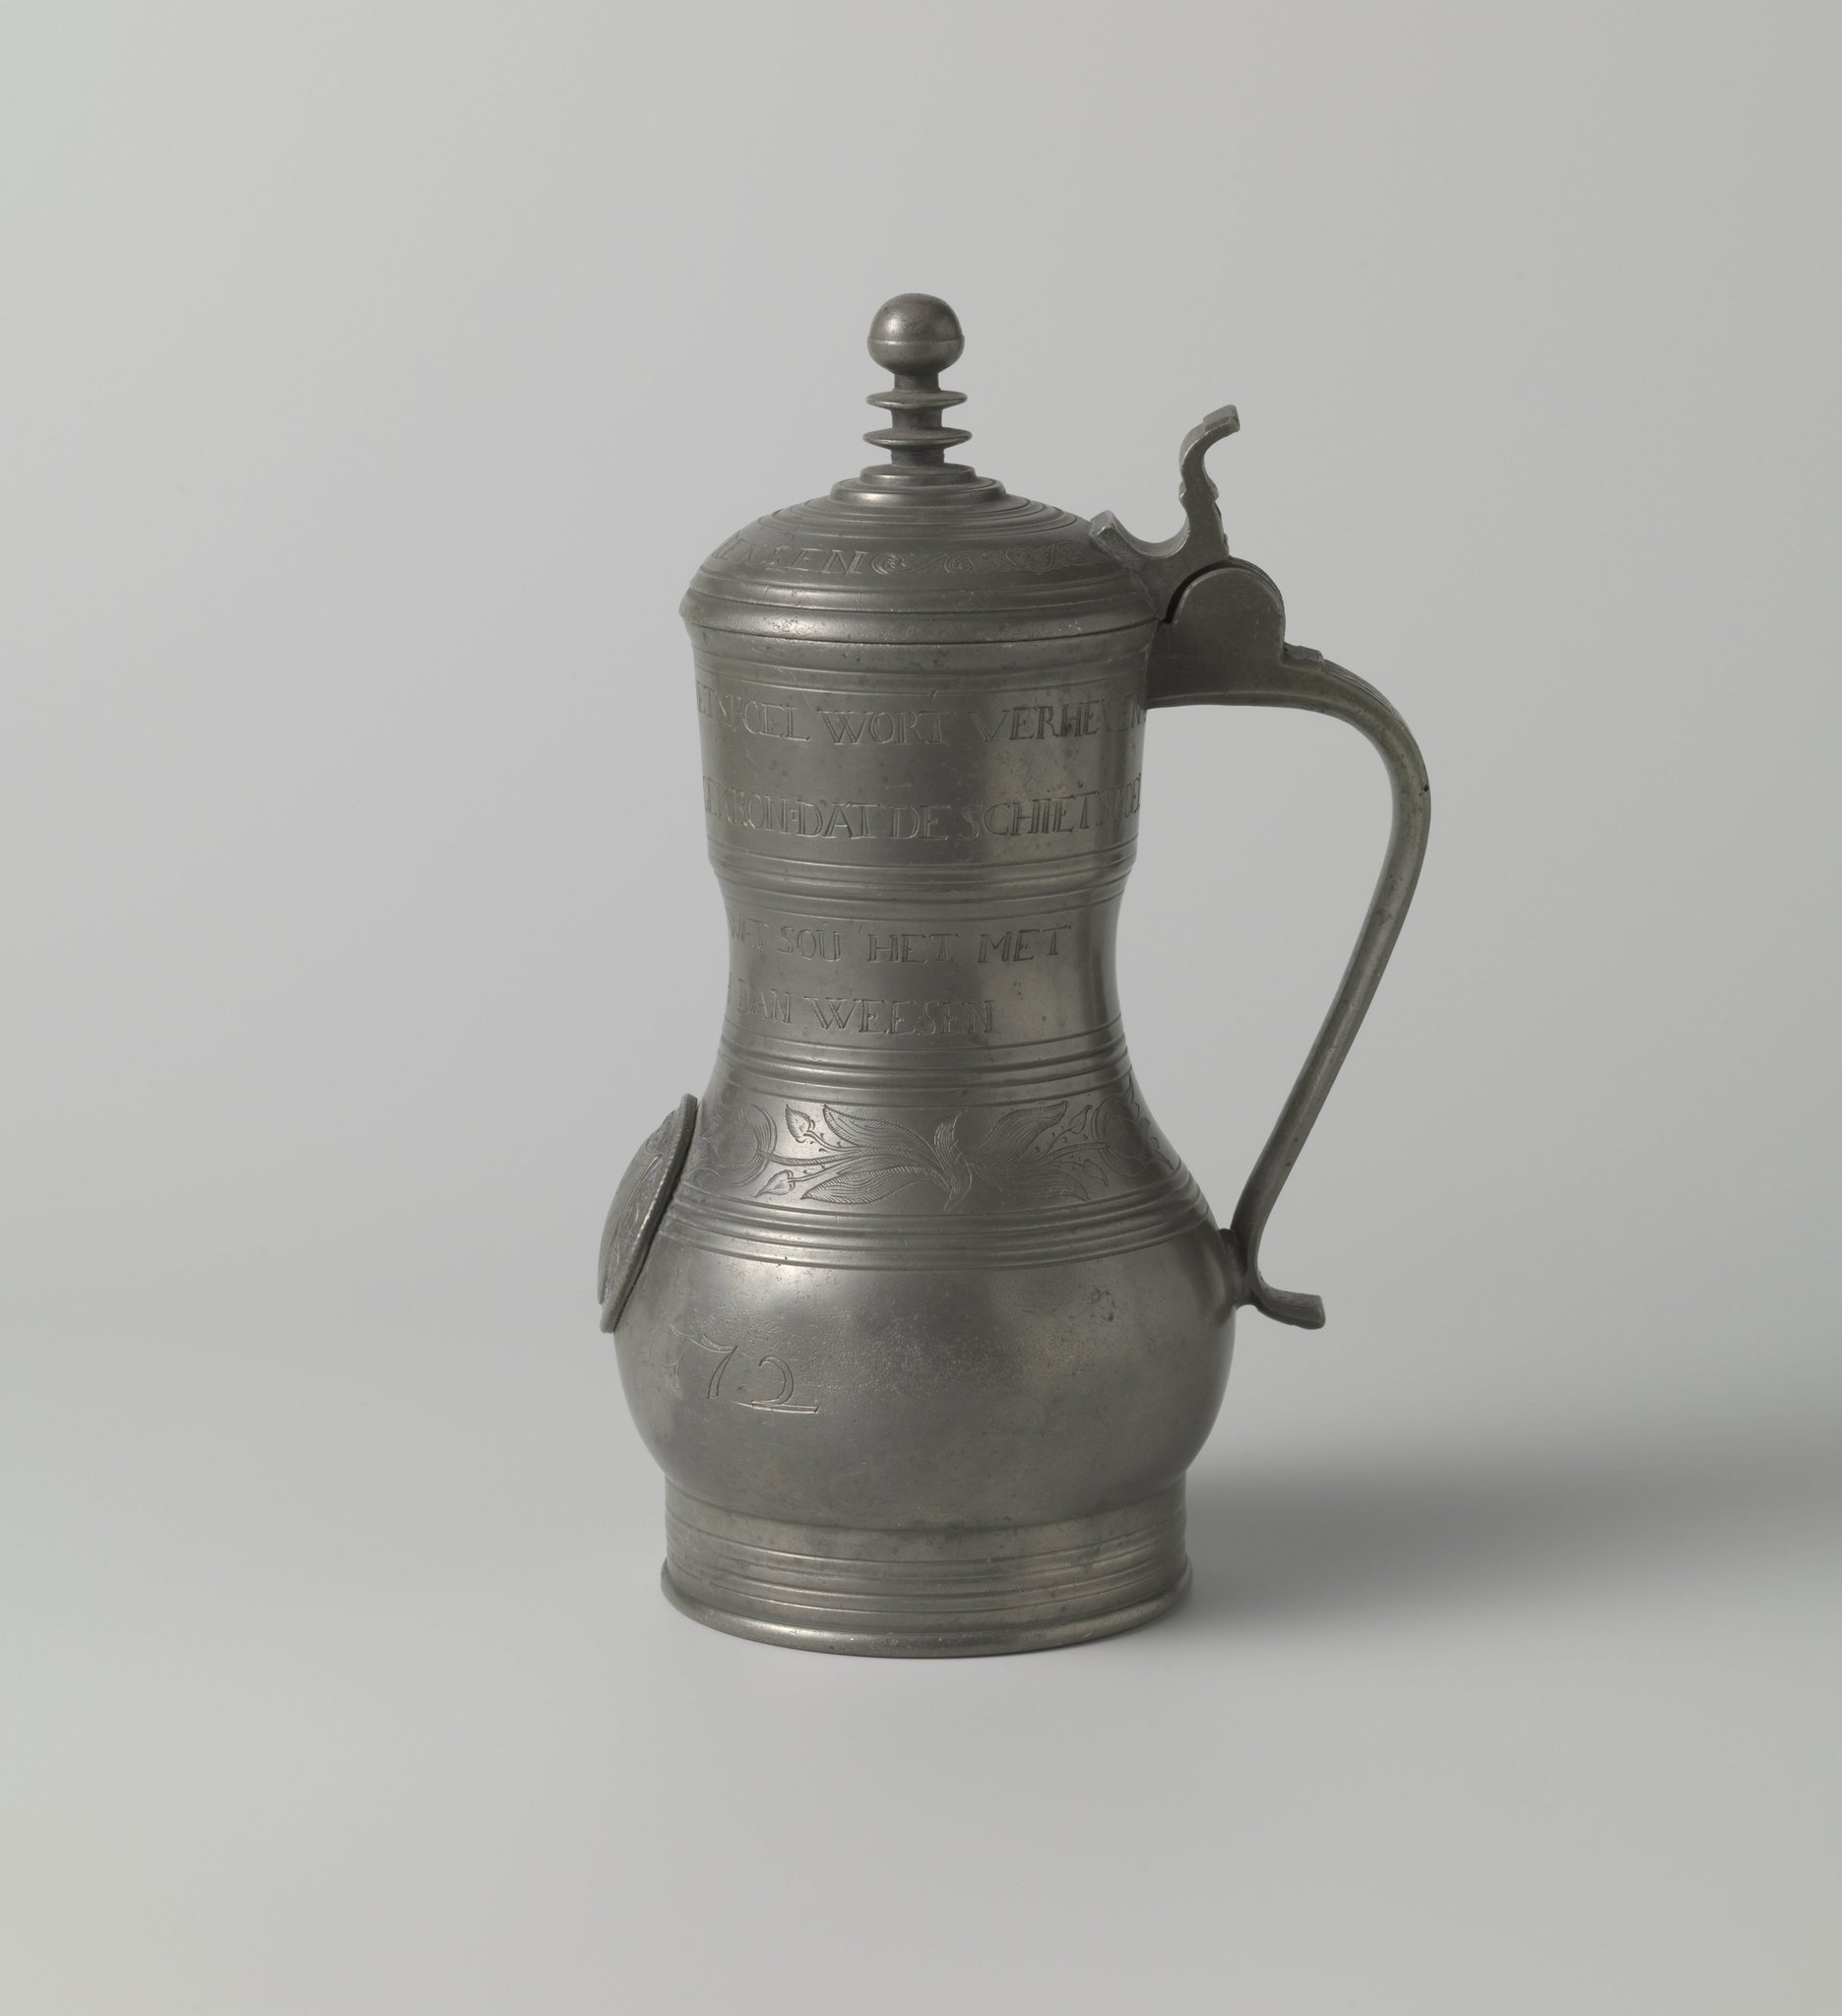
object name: jug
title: Gildekan van tin voor het werversgilde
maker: matthijs van ooyen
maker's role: pewterers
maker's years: 1679-1728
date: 1708-1772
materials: tin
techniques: casting, engraving, turning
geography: nijmegen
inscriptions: inscription: ‘PETER LAURENSEN’, quality mark, inscription: ‘O SALIG WEVEN DE SCHITESPOEL WORT VERHEVEN / DE SPHENROEKEN WORT GEKRON DAT DE SCHIETSPOEL / NIET WIERT GEDREVEN WAT SOU HET MET / DEN ARMEN MENSCH DAN WEESEN / ANNO 1772’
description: Gildekan van tin met deksel, waarop gesneden 'Peter Laurenden'. Op de buik een hoogliggend medaillon waarop gesneden het wapen van een weversgilde tussen 'Anno 1772' en tulpen aan een tak. Op de hals: "O. Salig weven - de schietspoel wort verheven, de sphenrocken wort gekront. Dat de schietspoel niet weert gedreven wat zou het met den armen mensch dan weeden.' Merk: een vijfbladige roos met kroon met in de rand M.v.G.